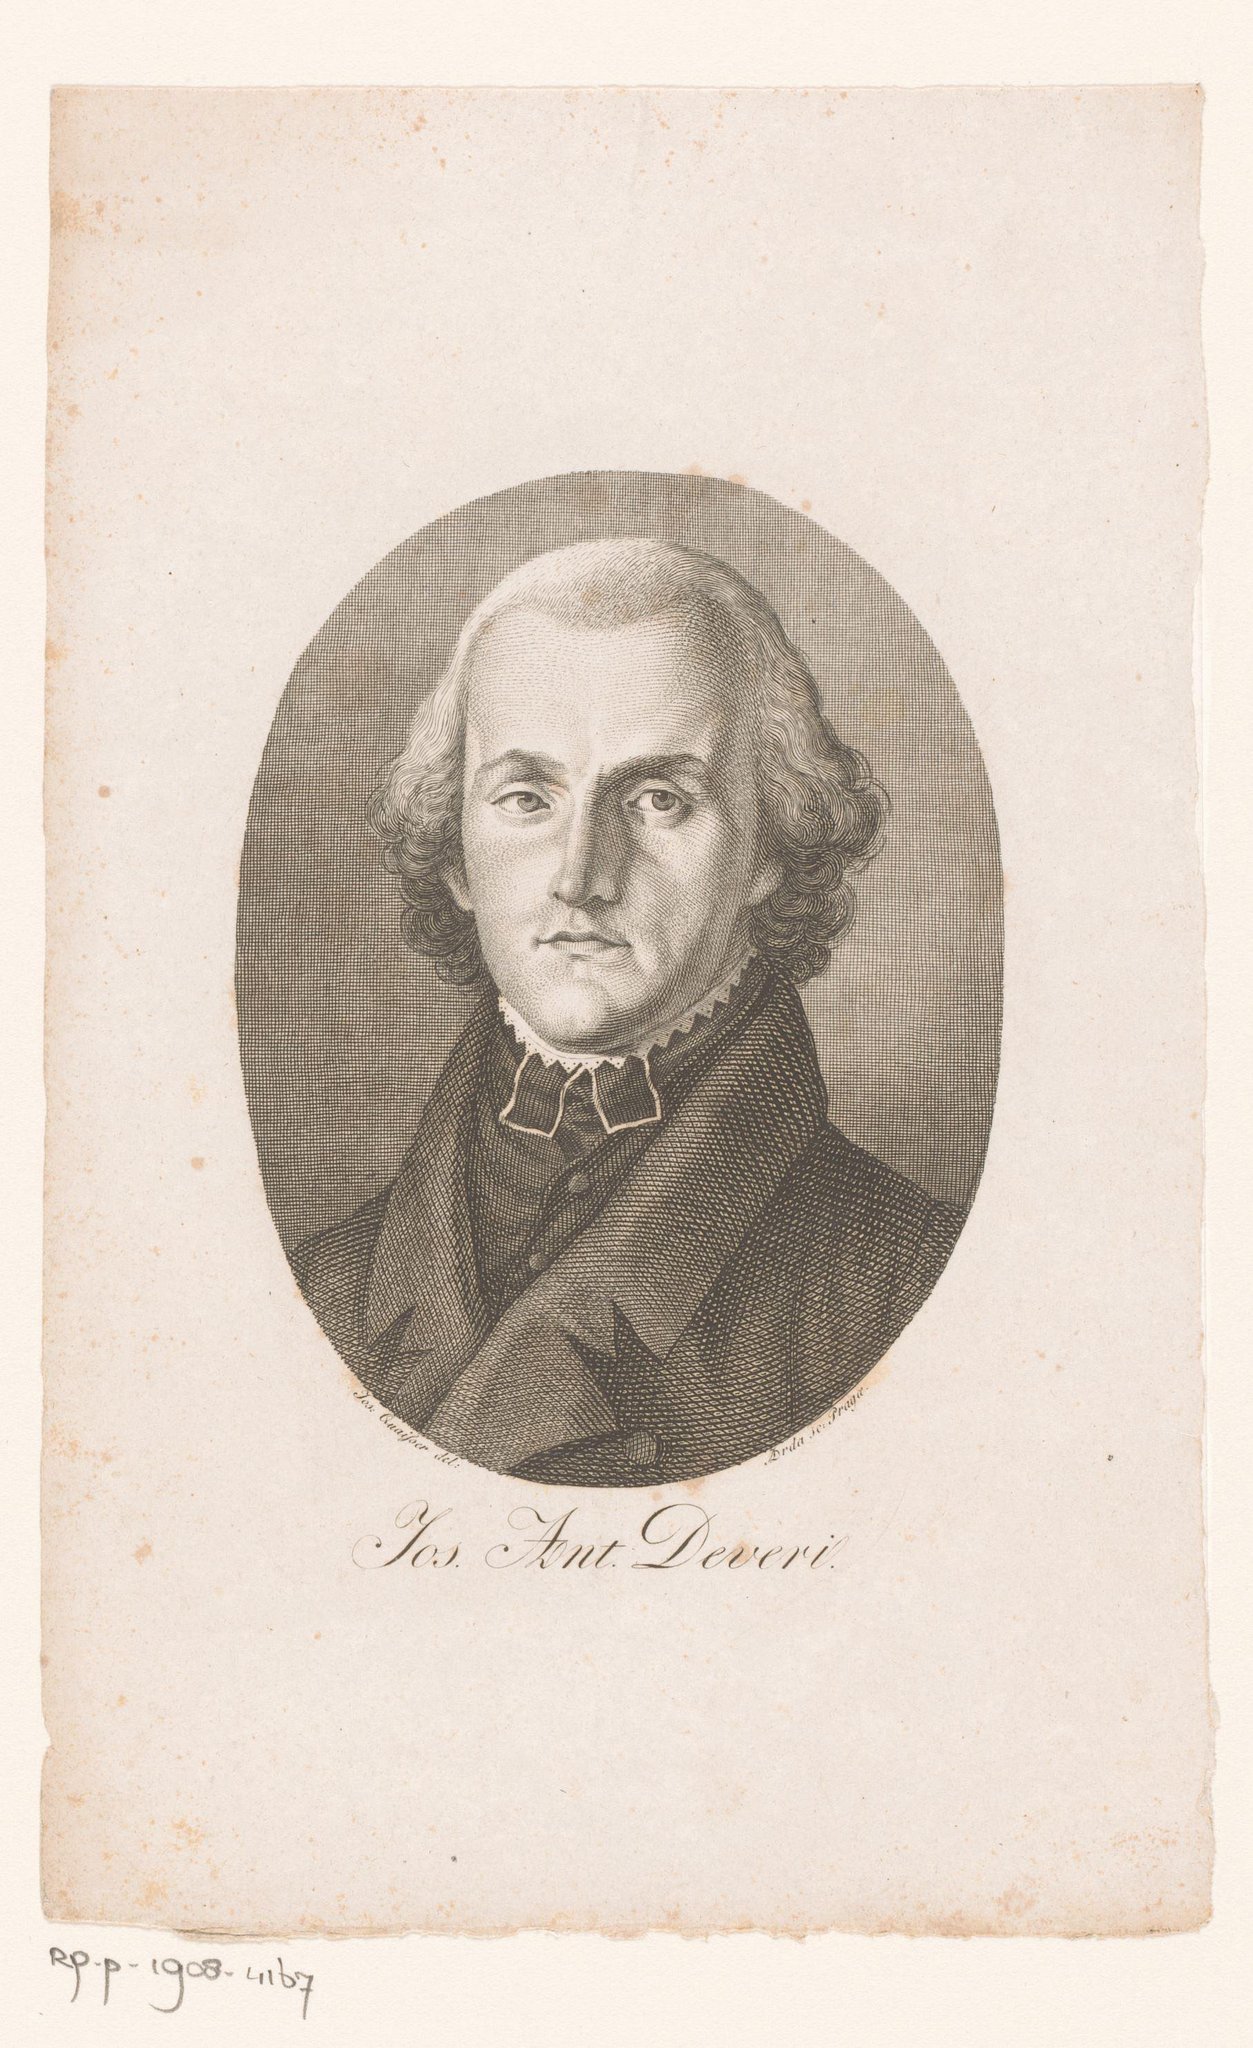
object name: print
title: Portret van Joseph Anton Deveri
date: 1793-1833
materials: paper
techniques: engraving, etching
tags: clergyman, historical persons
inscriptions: collector's mark: Lugt 2228